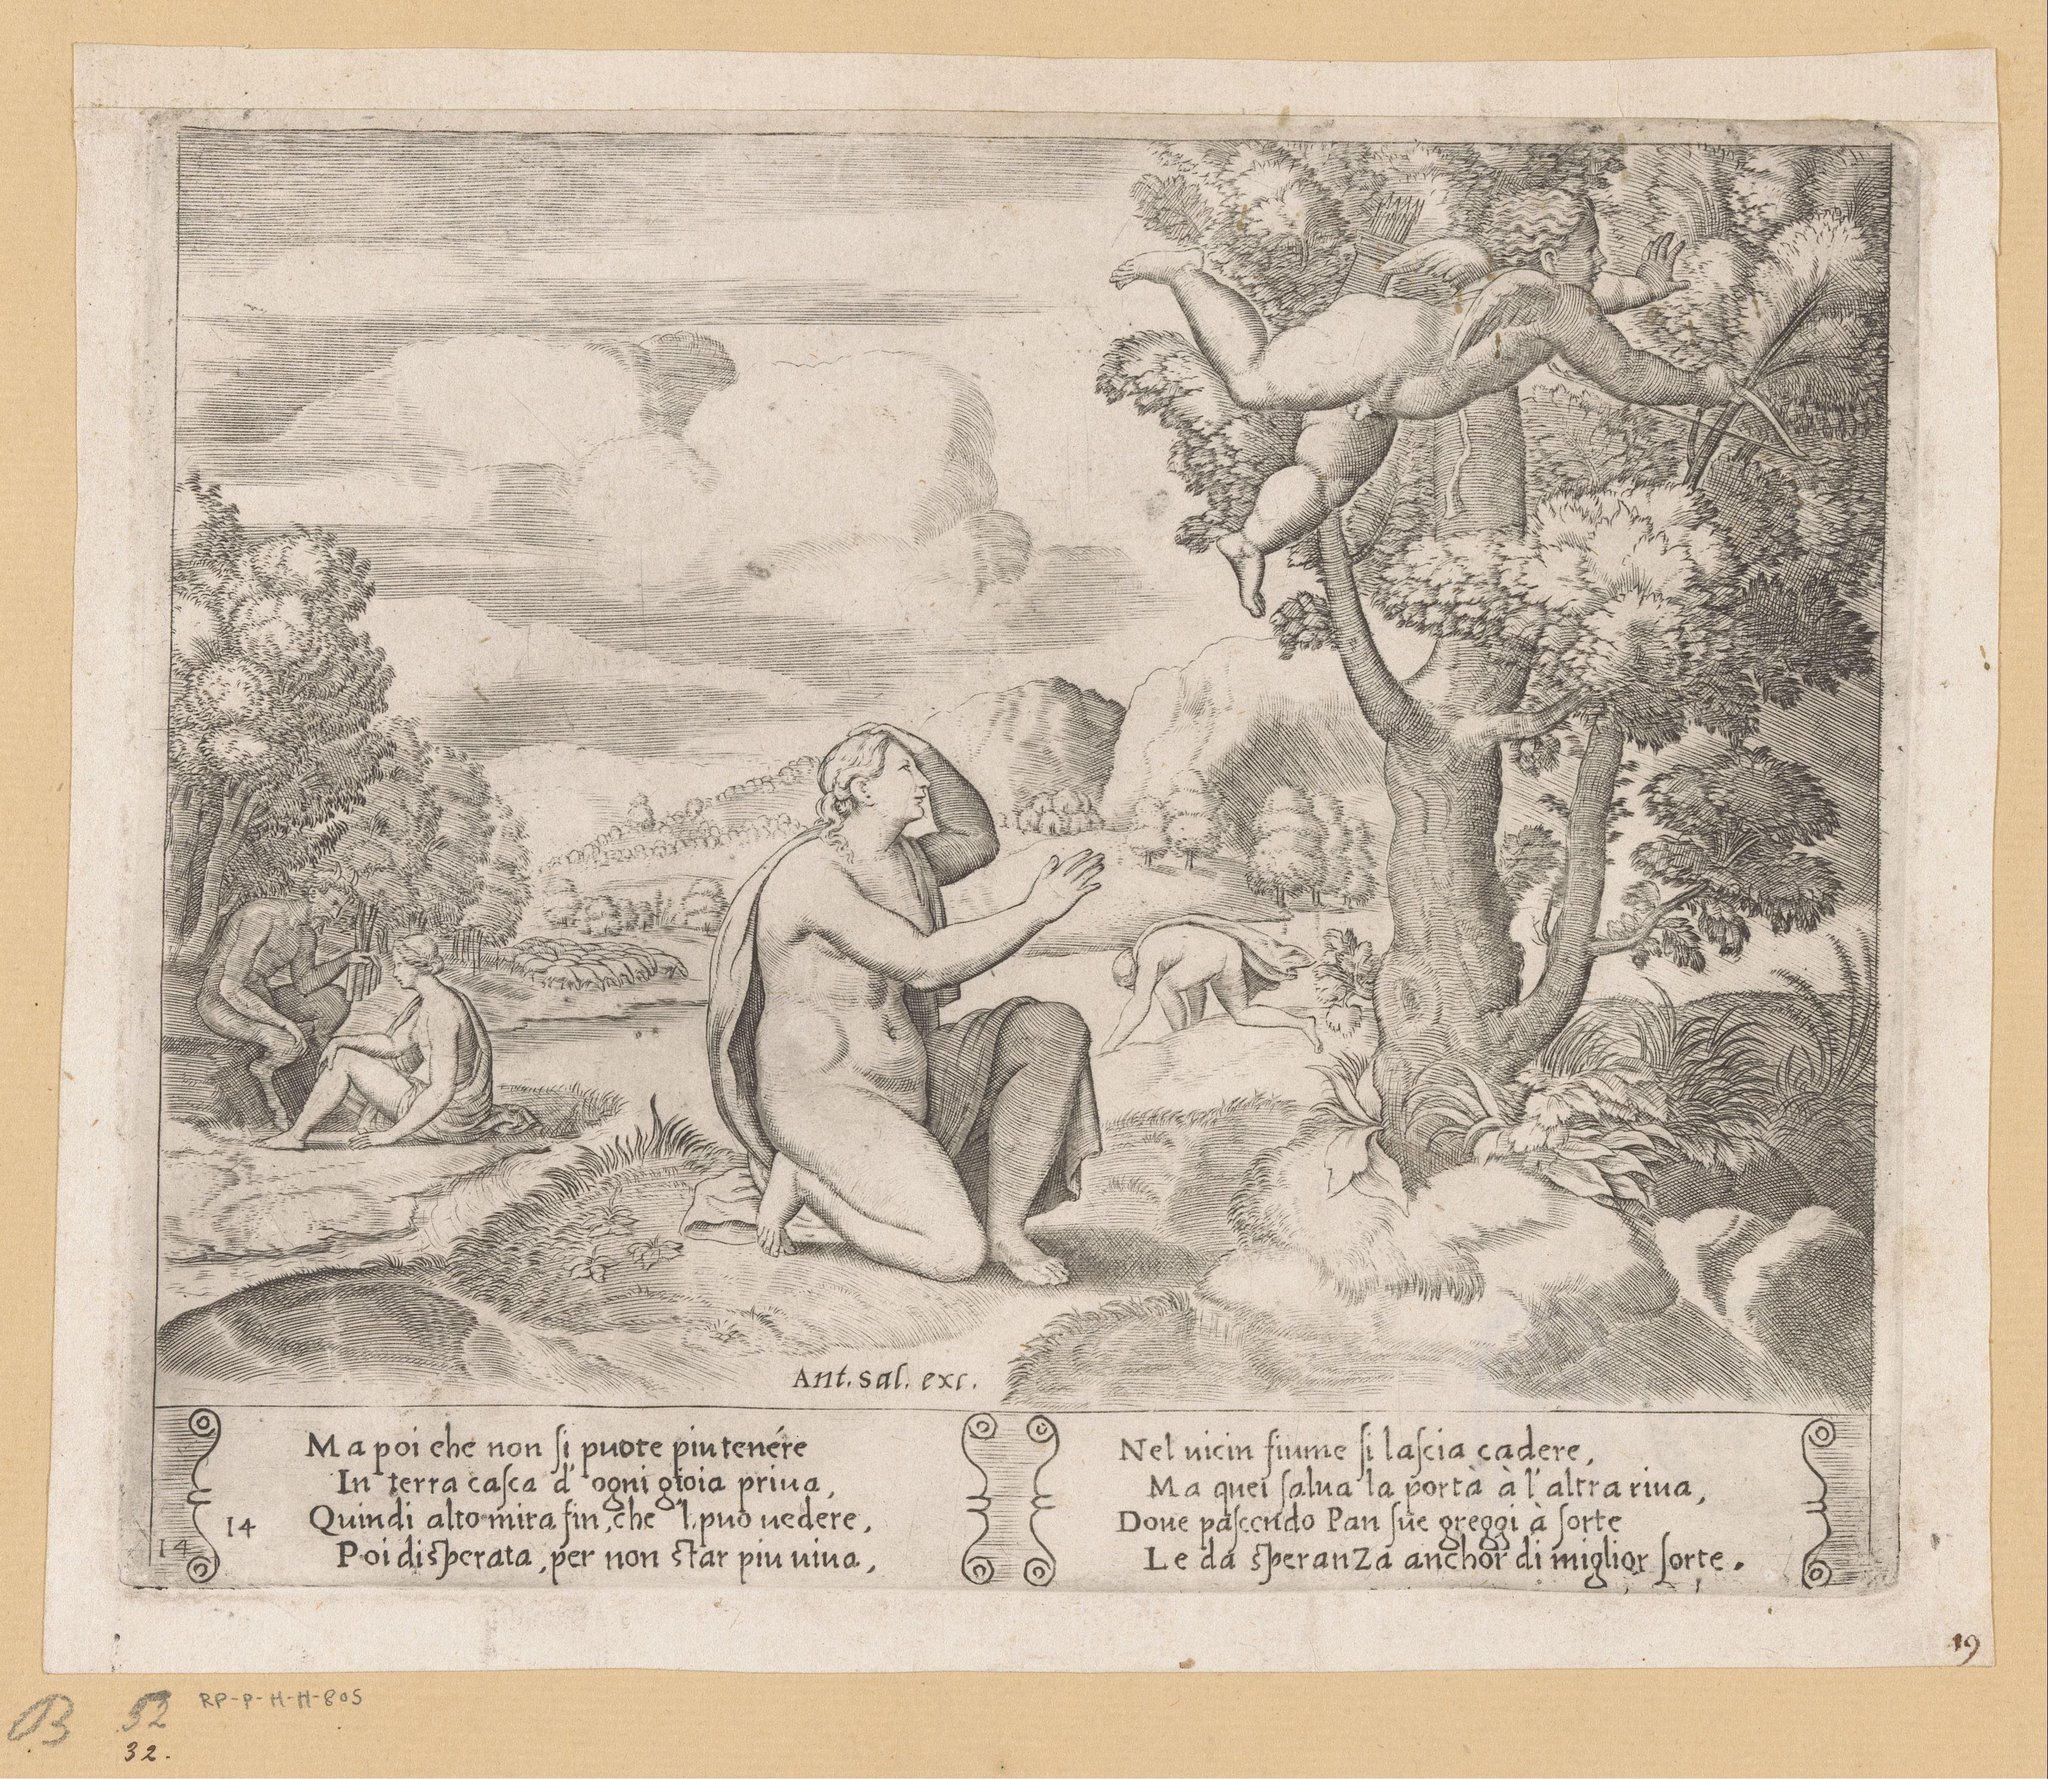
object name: print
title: Verhaal van Amor en Psyche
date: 1530-1560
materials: paper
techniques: engraving, intaglio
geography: rome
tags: cupid leaves the desperate psyche behind, psyche with pan and echo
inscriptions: collector's mark: Lugt 11, number: ‘19’, collector's mark: ‘Hinloopen’, collector's mark: Lugt 10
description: In een landschap zit de koningsdochter Psyche terwijl ze verlaten wordt door haar geliefde Amor. Op de achtergrond probeert Psyche zich in een rivier te storten en wordt zij getroost door de god Pan. Italiaanse tekst in twee cartouches in ondermarge. Tweemaal genummerd linksonder: 14.